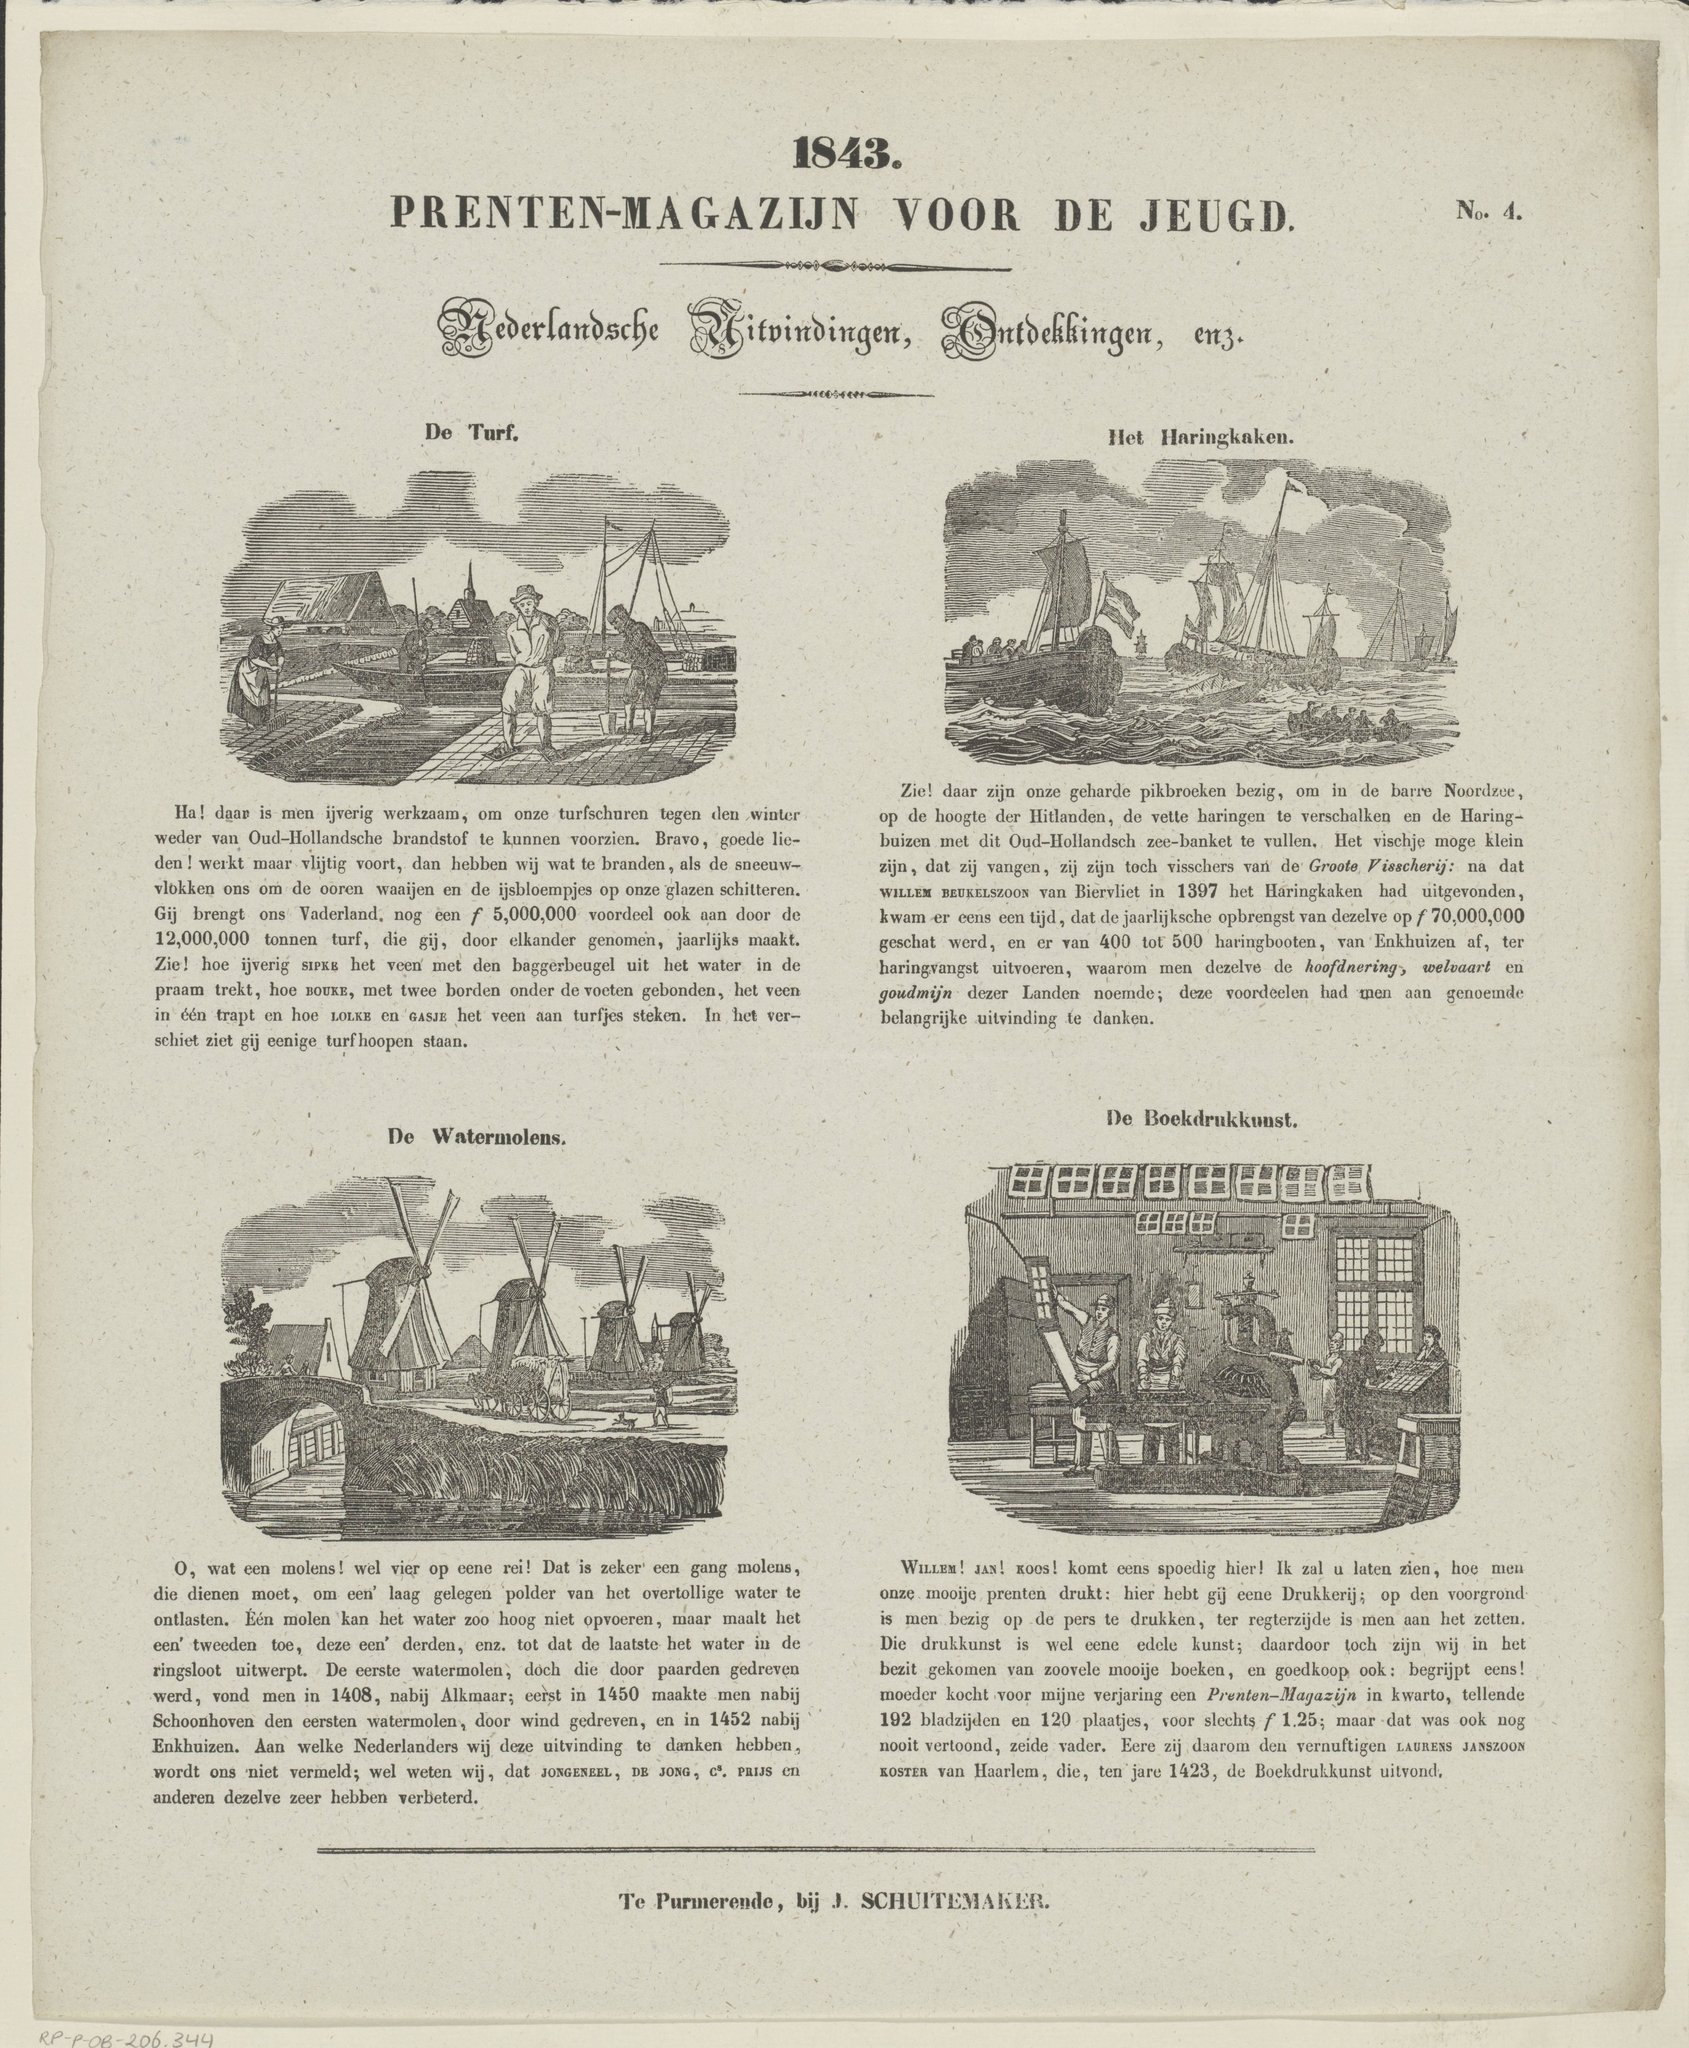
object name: print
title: Uitvindingen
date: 1843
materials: paper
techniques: letterpress printing, engraving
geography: purmerend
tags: peat (soil type), peat-cutting, herring fishery, printing press, printing, printing office, watermill, watermill in landscape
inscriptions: collector's mark: Lugt 2760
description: Blad met 4 voorstellingen van Nederlandse uitvindingen en ontdekkingen: turf, het haring kaken, watermolens en de boekdrukkunst. Boven elke voorstelling een titel en onder elke voorstelling een onderschrift. Genummerd rechtsboven: No. 4.